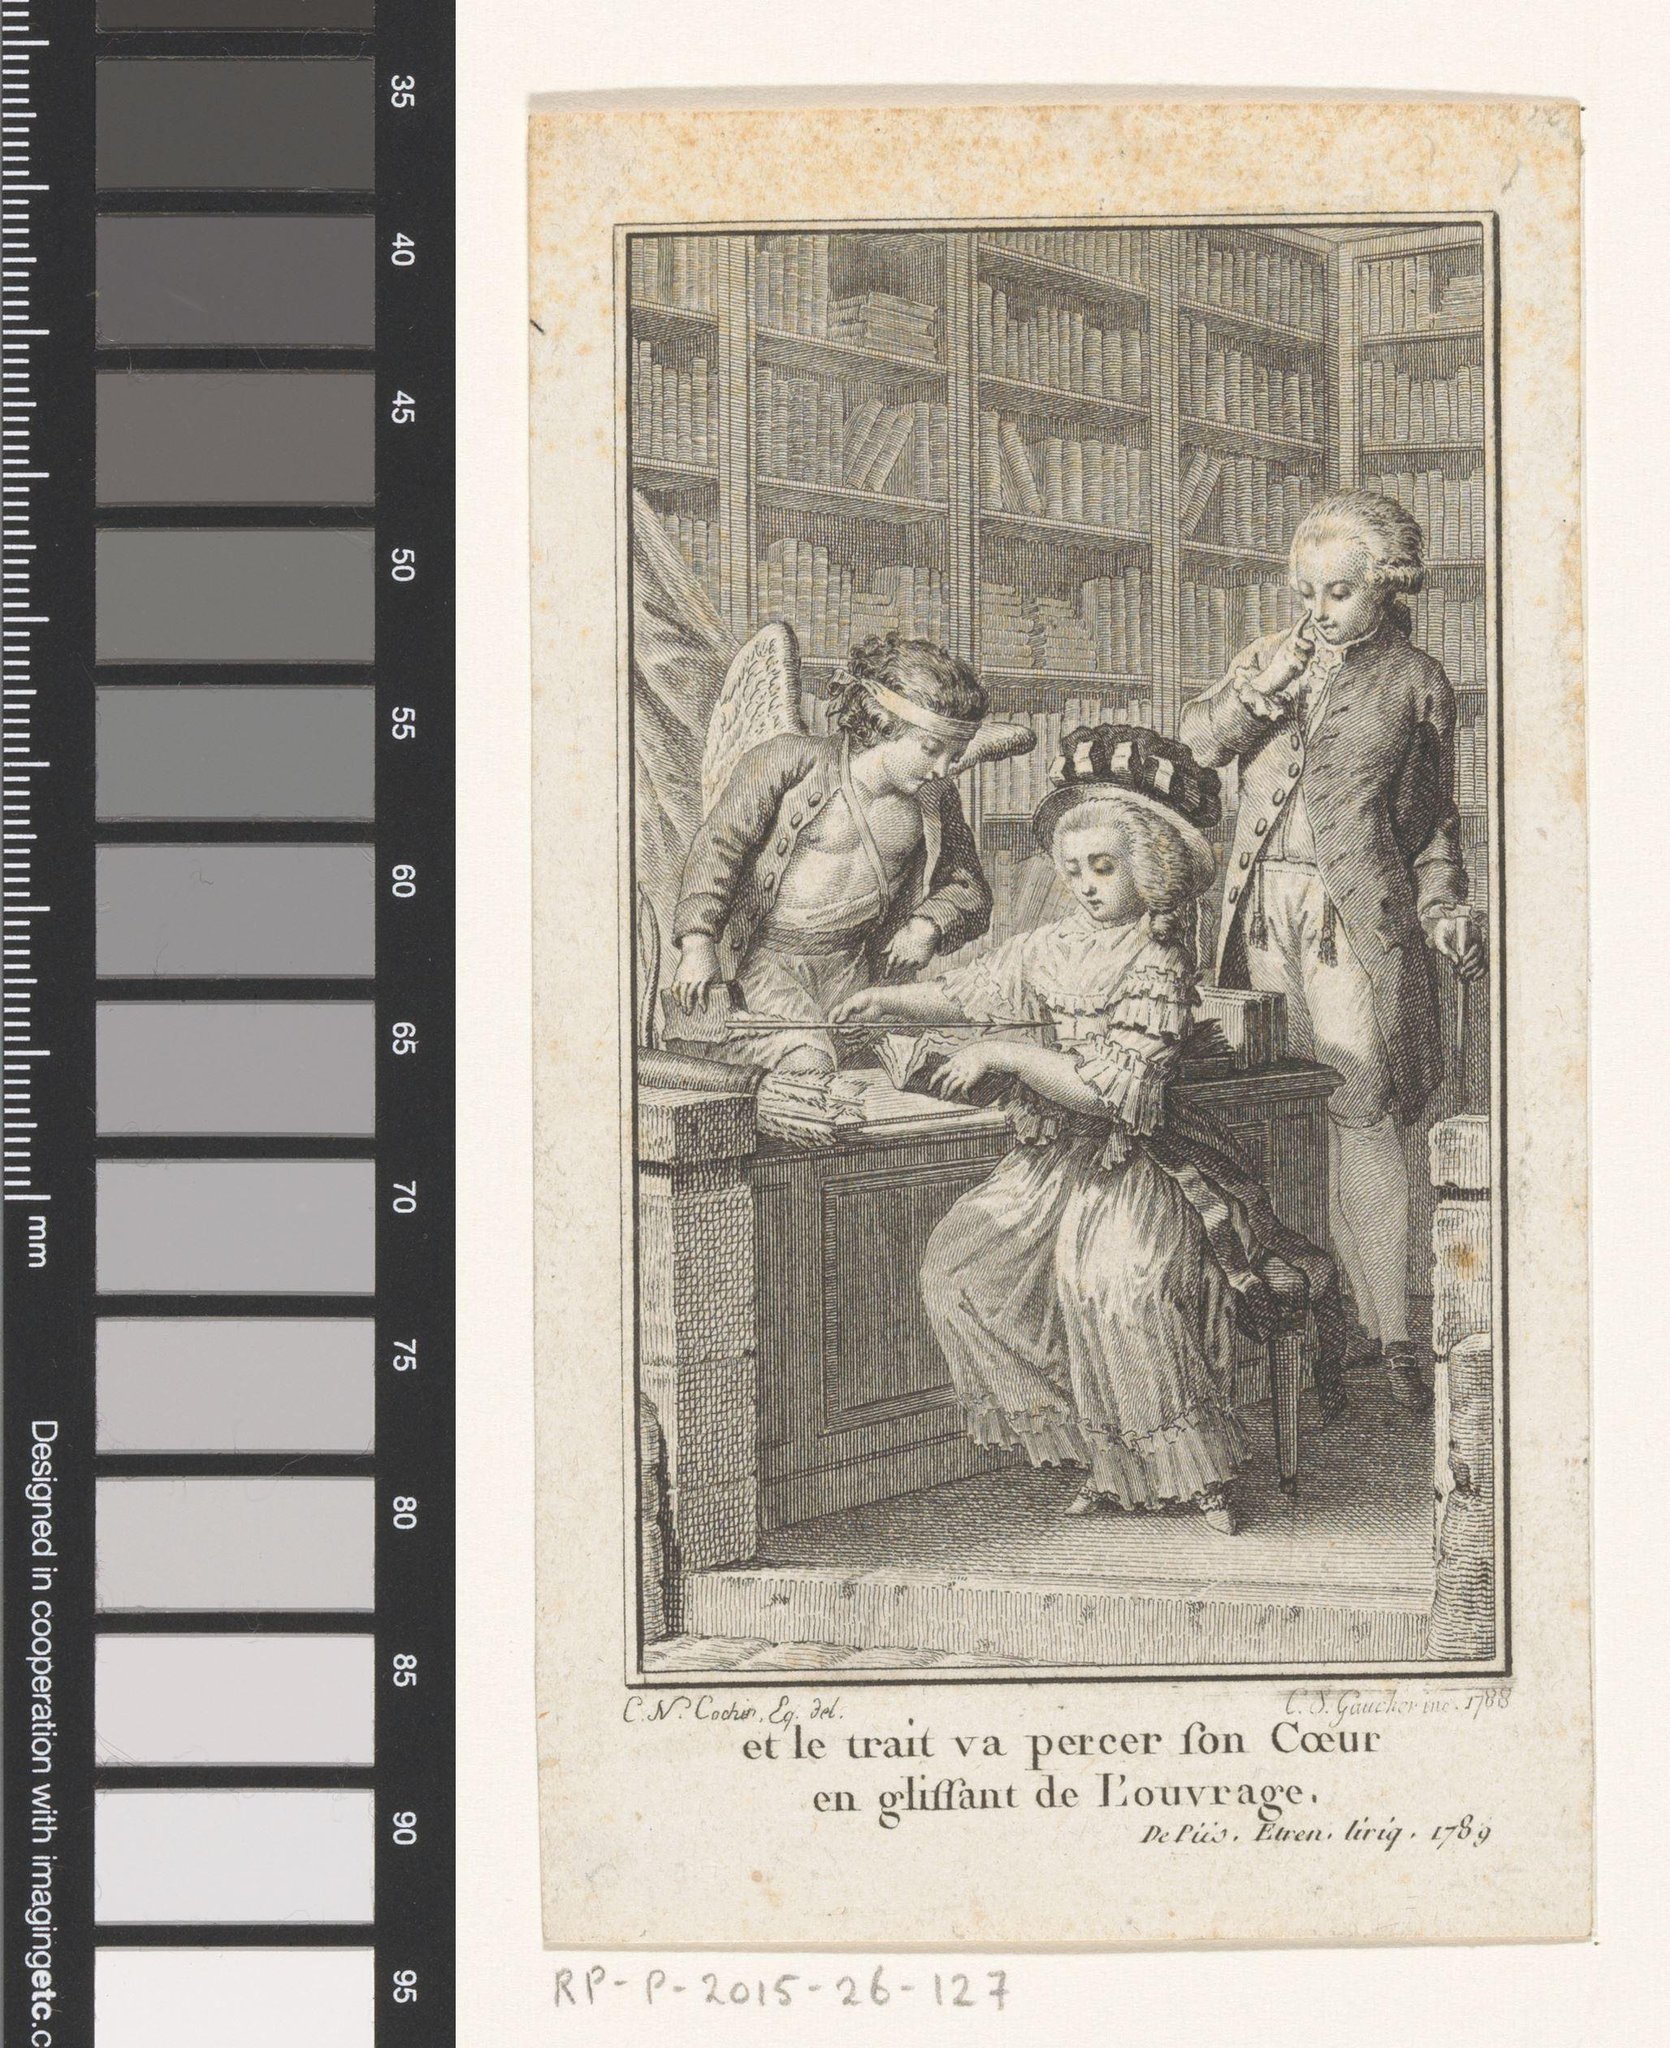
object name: print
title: Cupido als boekverkoper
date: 1788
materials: paper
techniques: etching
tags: other non-aggressive activities of cupid, merchant, salesman, book-shop, bookseller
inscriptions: collector's mark: Lugt 2228, collector's mark: Lugt 4780, collector's mark: ‘Litmour Libraire’, collector's mark: Lugt 4779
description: Interieur van een boekhandel met Cupido achter de toonbank. Voor de toonbank zit een jonge vrouw, zij snijdt een boek open met een pijl, de punt op haar hart gericht. Achter haar kijkt een jongeman belangstellend toe.